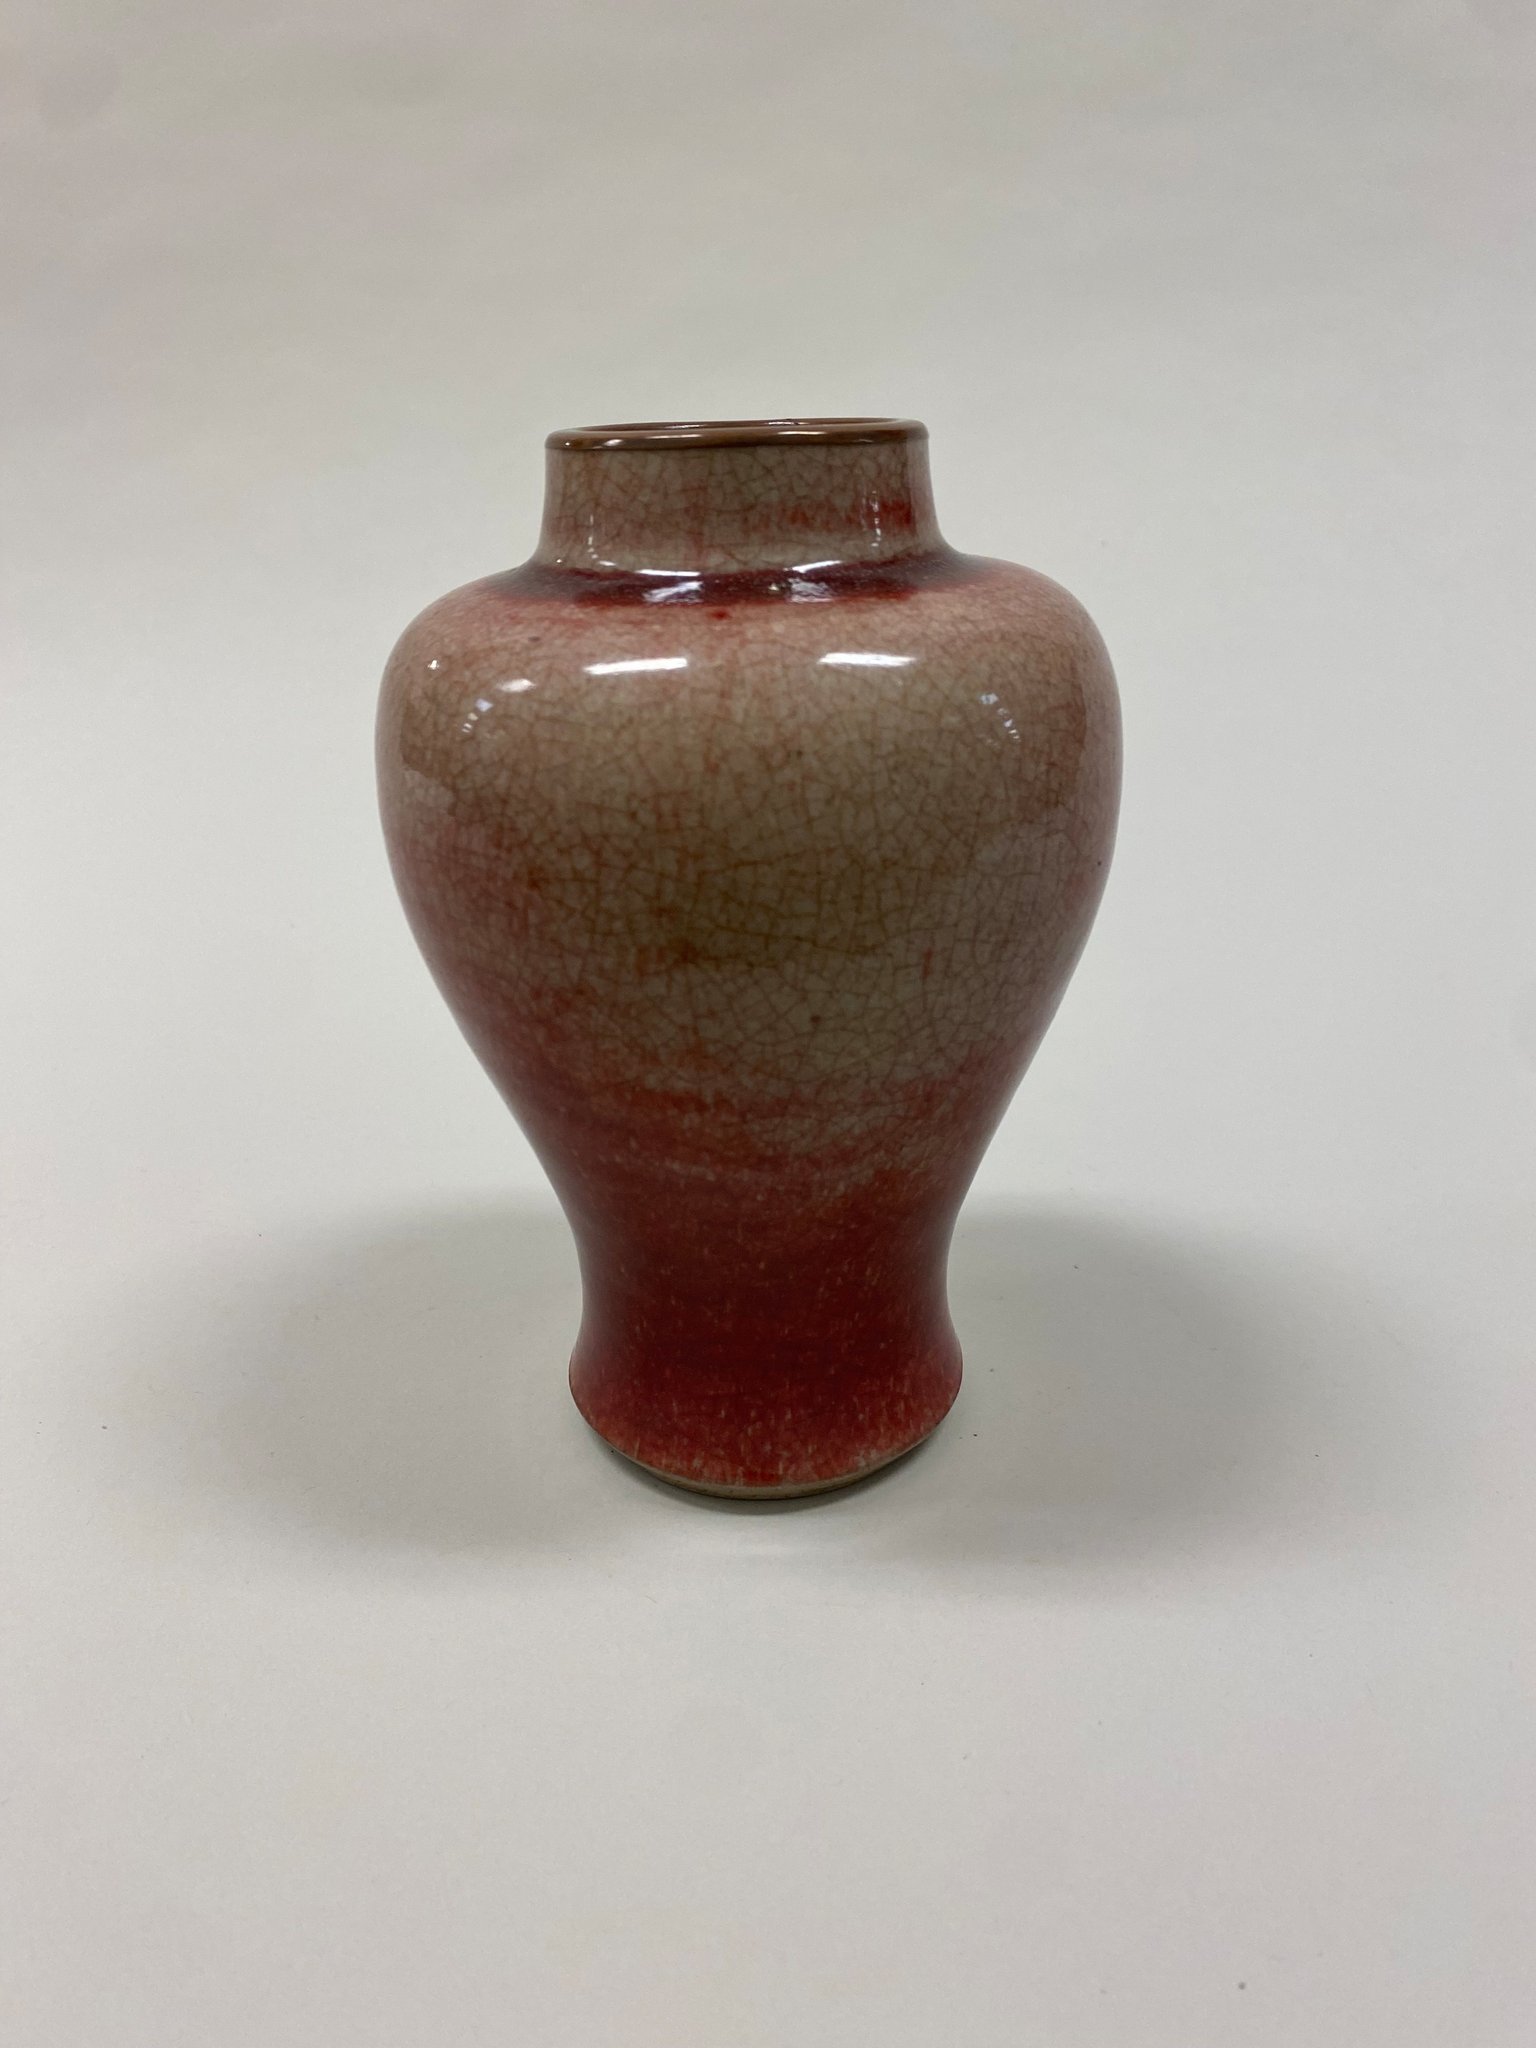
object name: vase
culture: chinese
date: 1667-1733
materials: glaze, porcelain